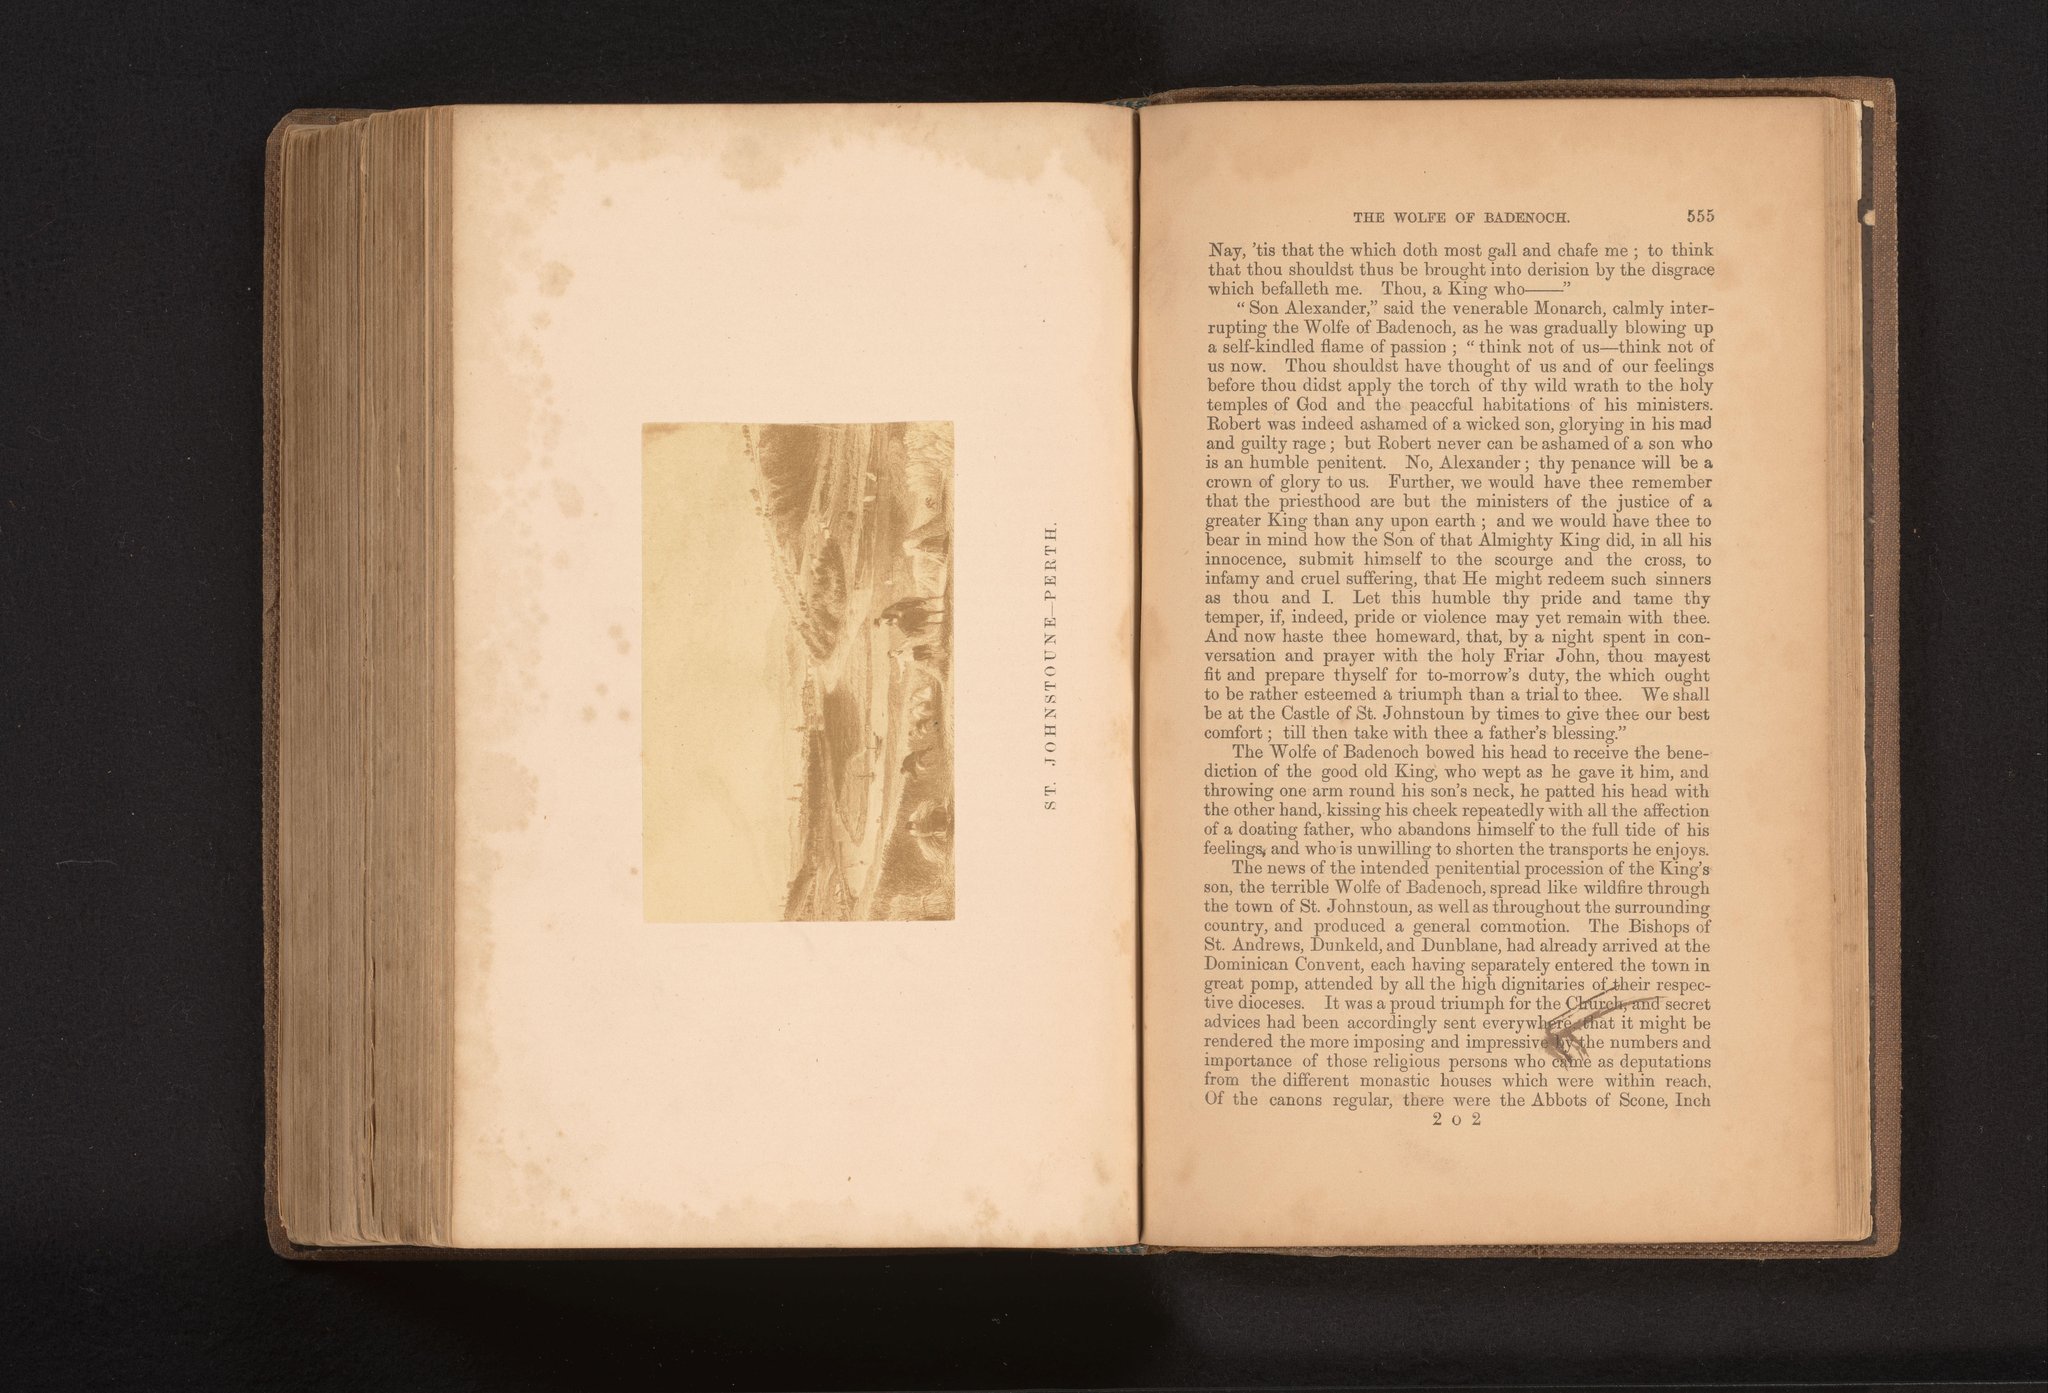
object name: reproduction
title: Fotoreproductie van een ontwerp van St. Johnstone bij Perth, Schotland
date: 1858-1863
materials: photographic support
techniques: albumen print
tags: landscapes (+ landscape with figures, staffage)